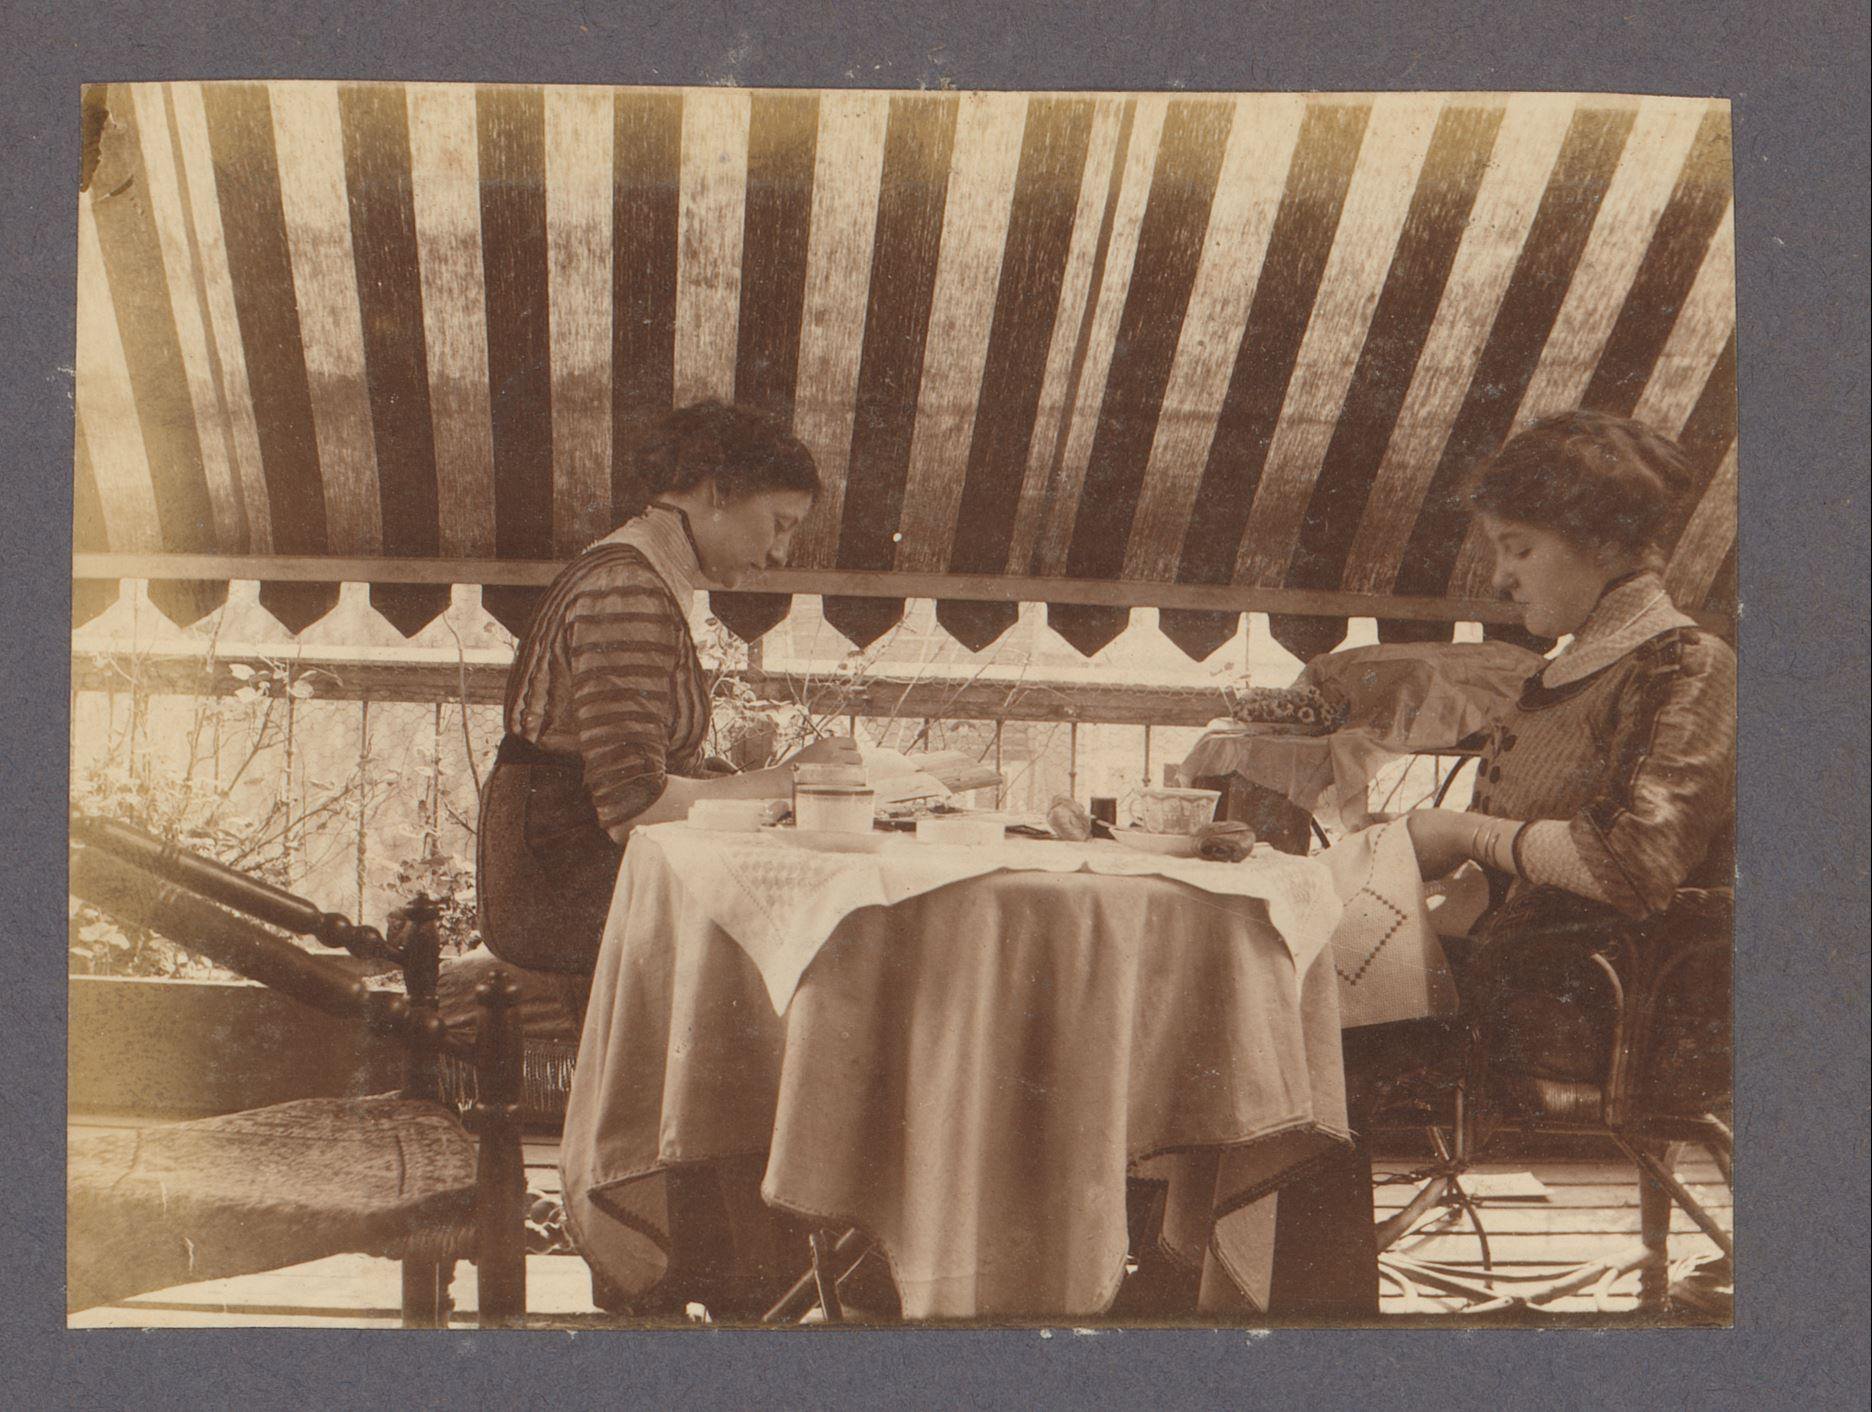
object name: photograph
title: Twee vrouwen met borduurwerk op een terras aan tafel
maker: cornelis johannes lodewicus vermeulen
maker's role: fotograaf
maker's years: 1861-1936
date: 1900-1925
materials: photographic support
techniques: gelatin silver print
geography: the hague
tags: adult woman, embroidery (ornamentation)